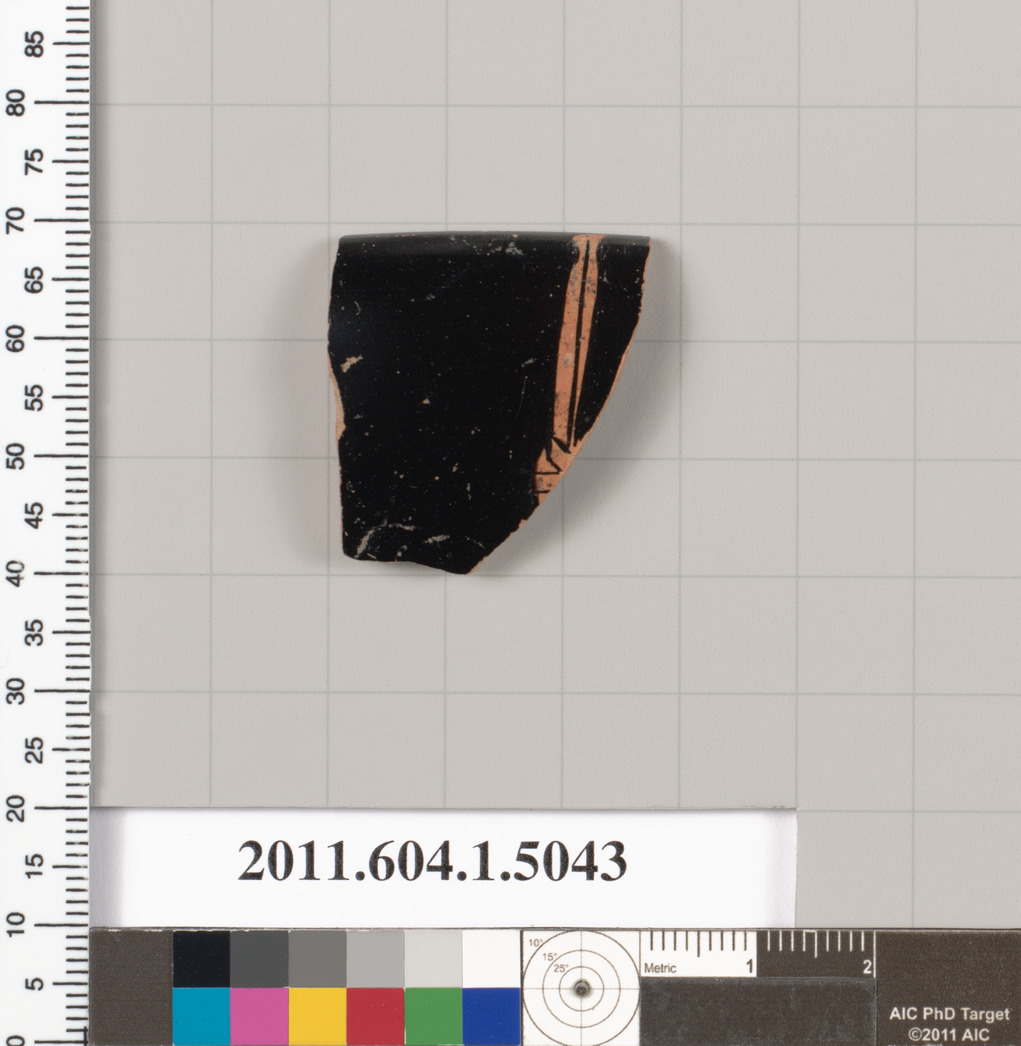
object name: kylix fragment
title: Terracotta fragment of a kylix (drinking cup)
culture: greek, attic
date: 467-435 BCE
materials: terracotta